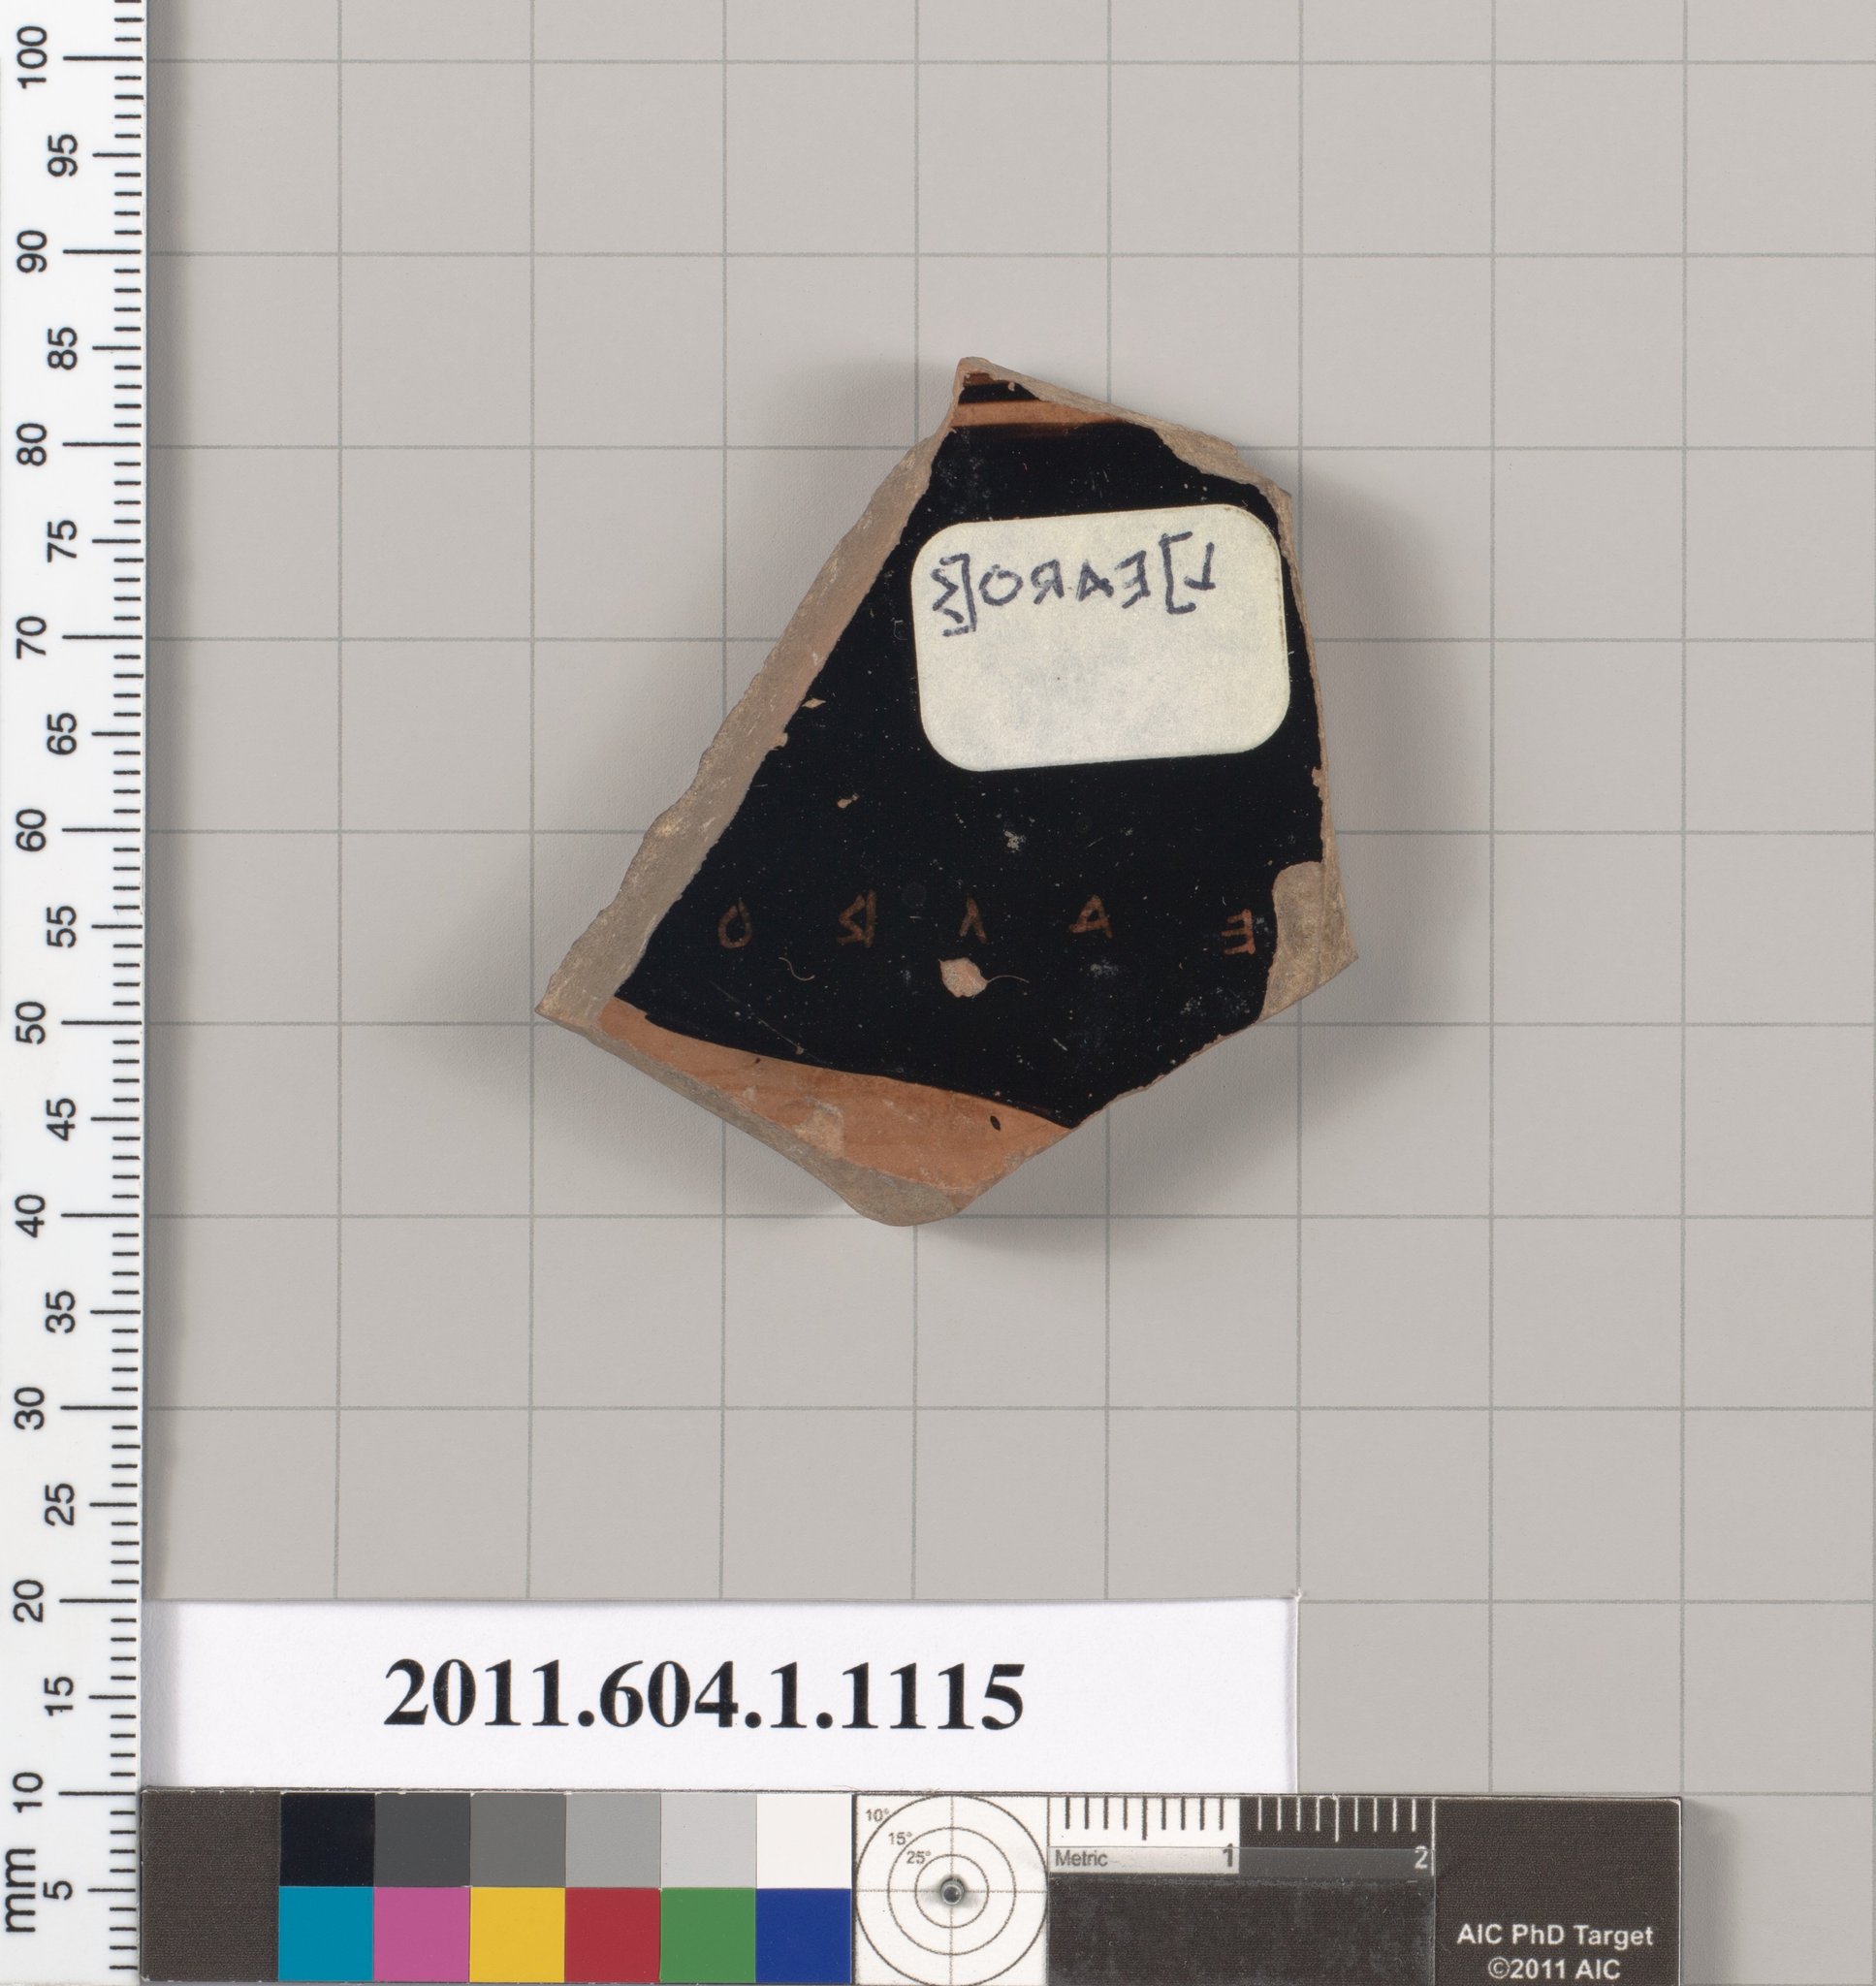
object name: kylix fragment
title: Terracotta fragment of a kylix (drinking cup)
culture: greek, attic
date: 510-500 BCE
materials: terracotta